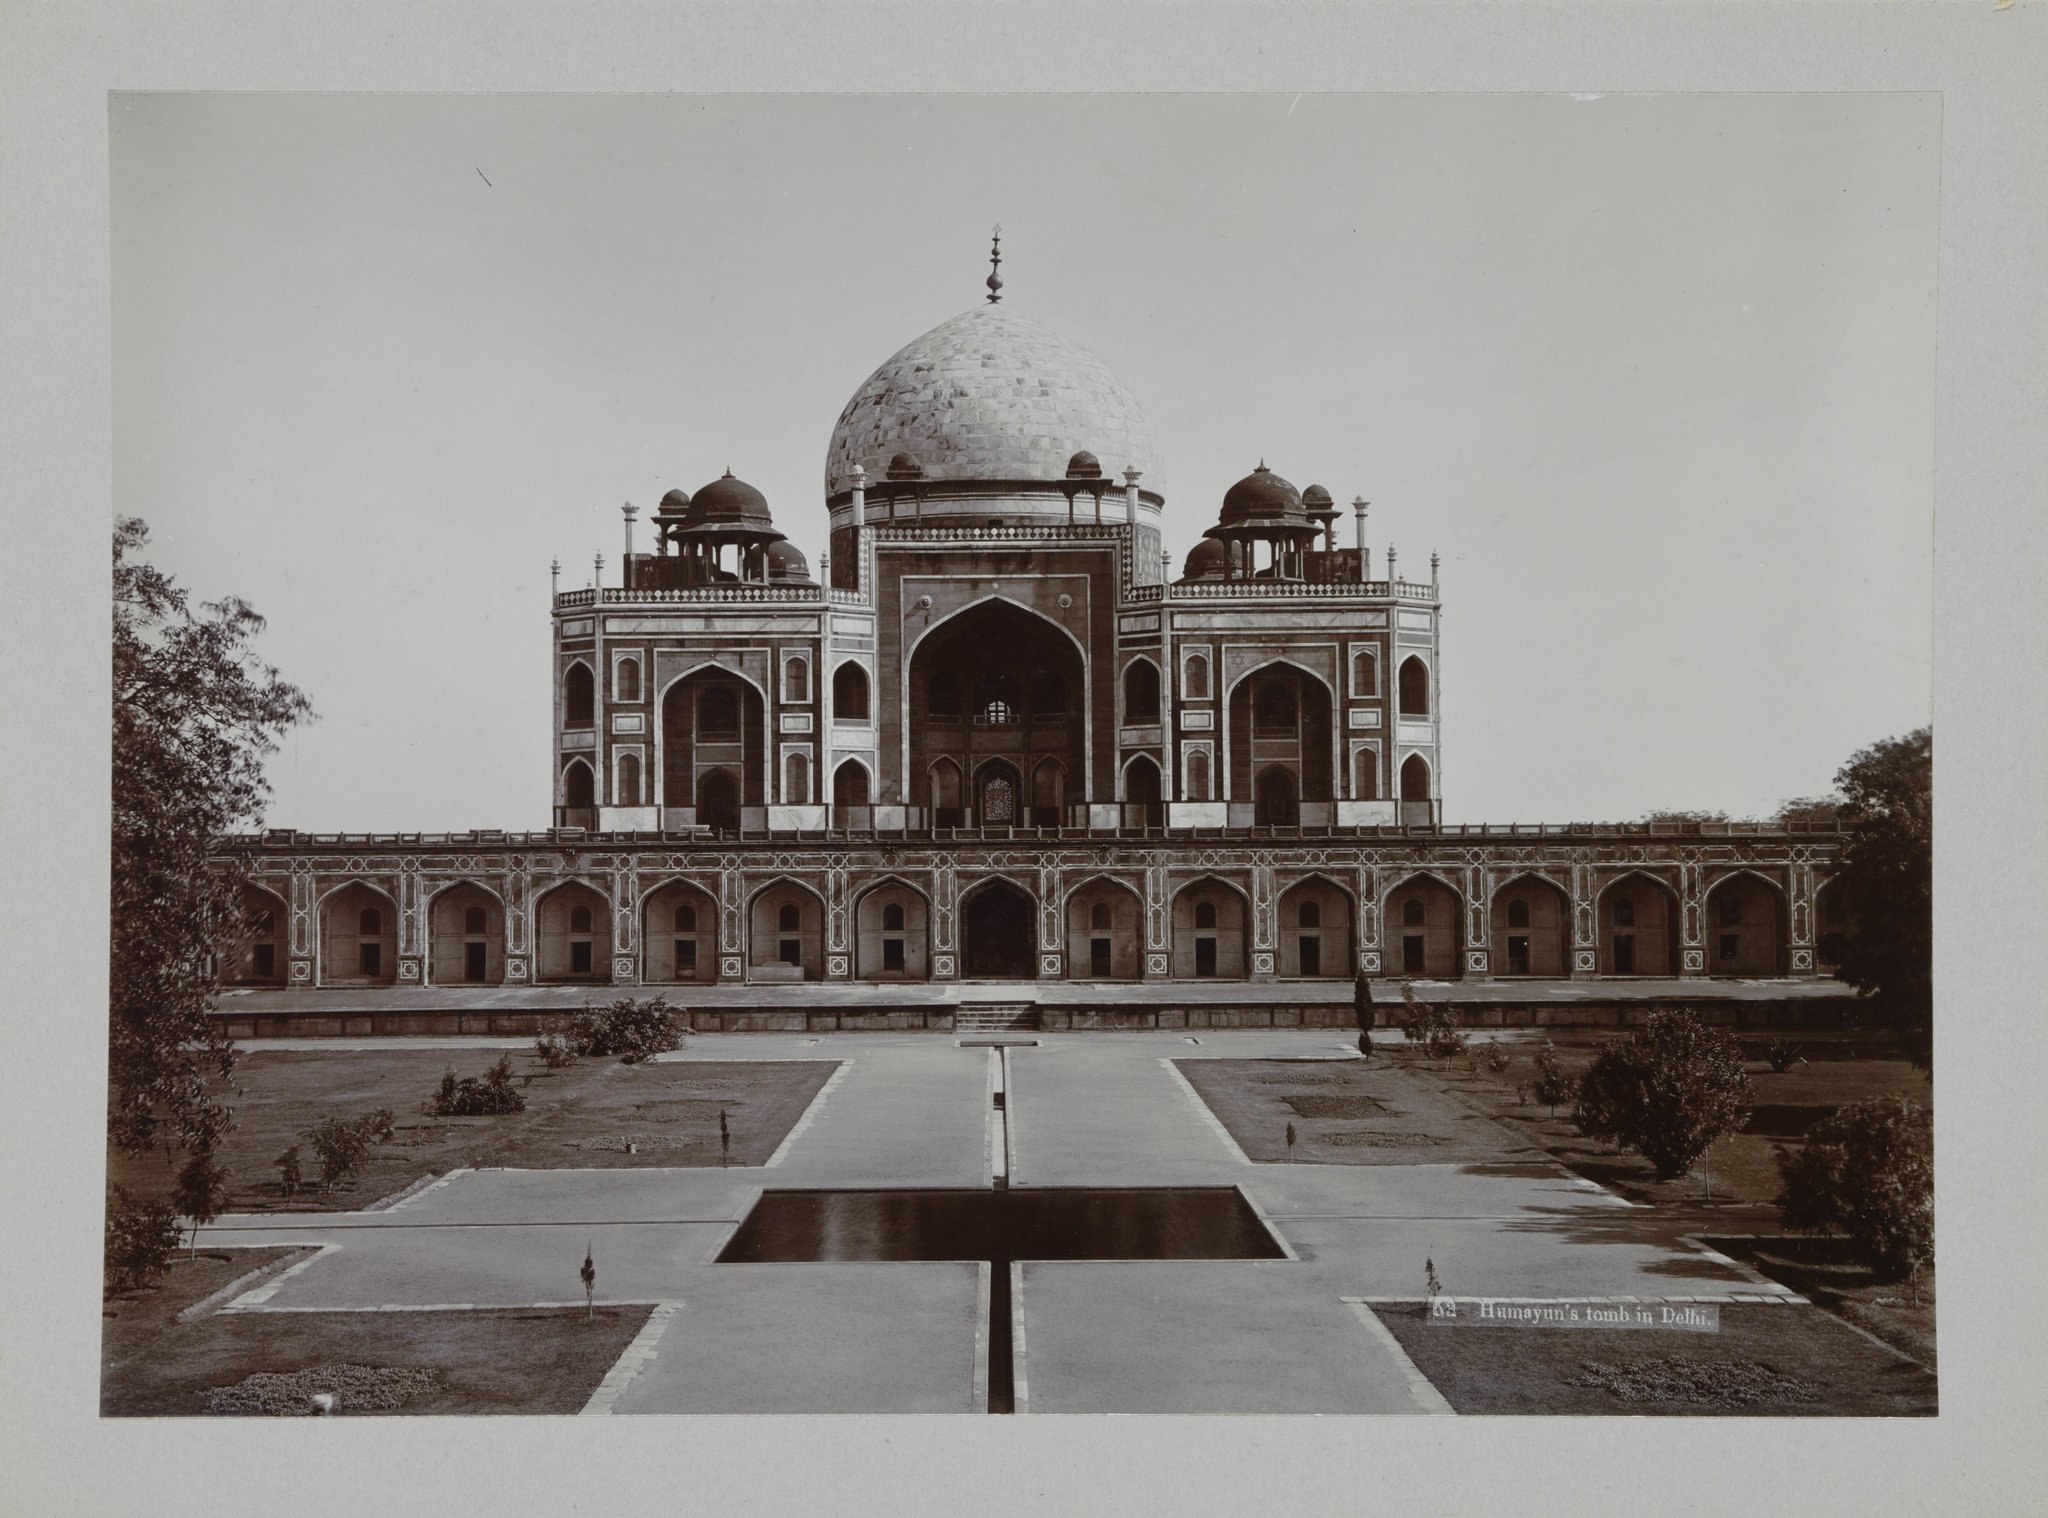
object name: photograph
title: Humayun's Tomb, Delhi, India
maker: Anonymous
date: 1895-1915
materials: cardboard, paper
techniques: gelatin silver print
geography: delhi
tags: mausoleum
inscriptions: number: ‘35.’, inscription: ‘53. Humayun's tomb in Delhi.’